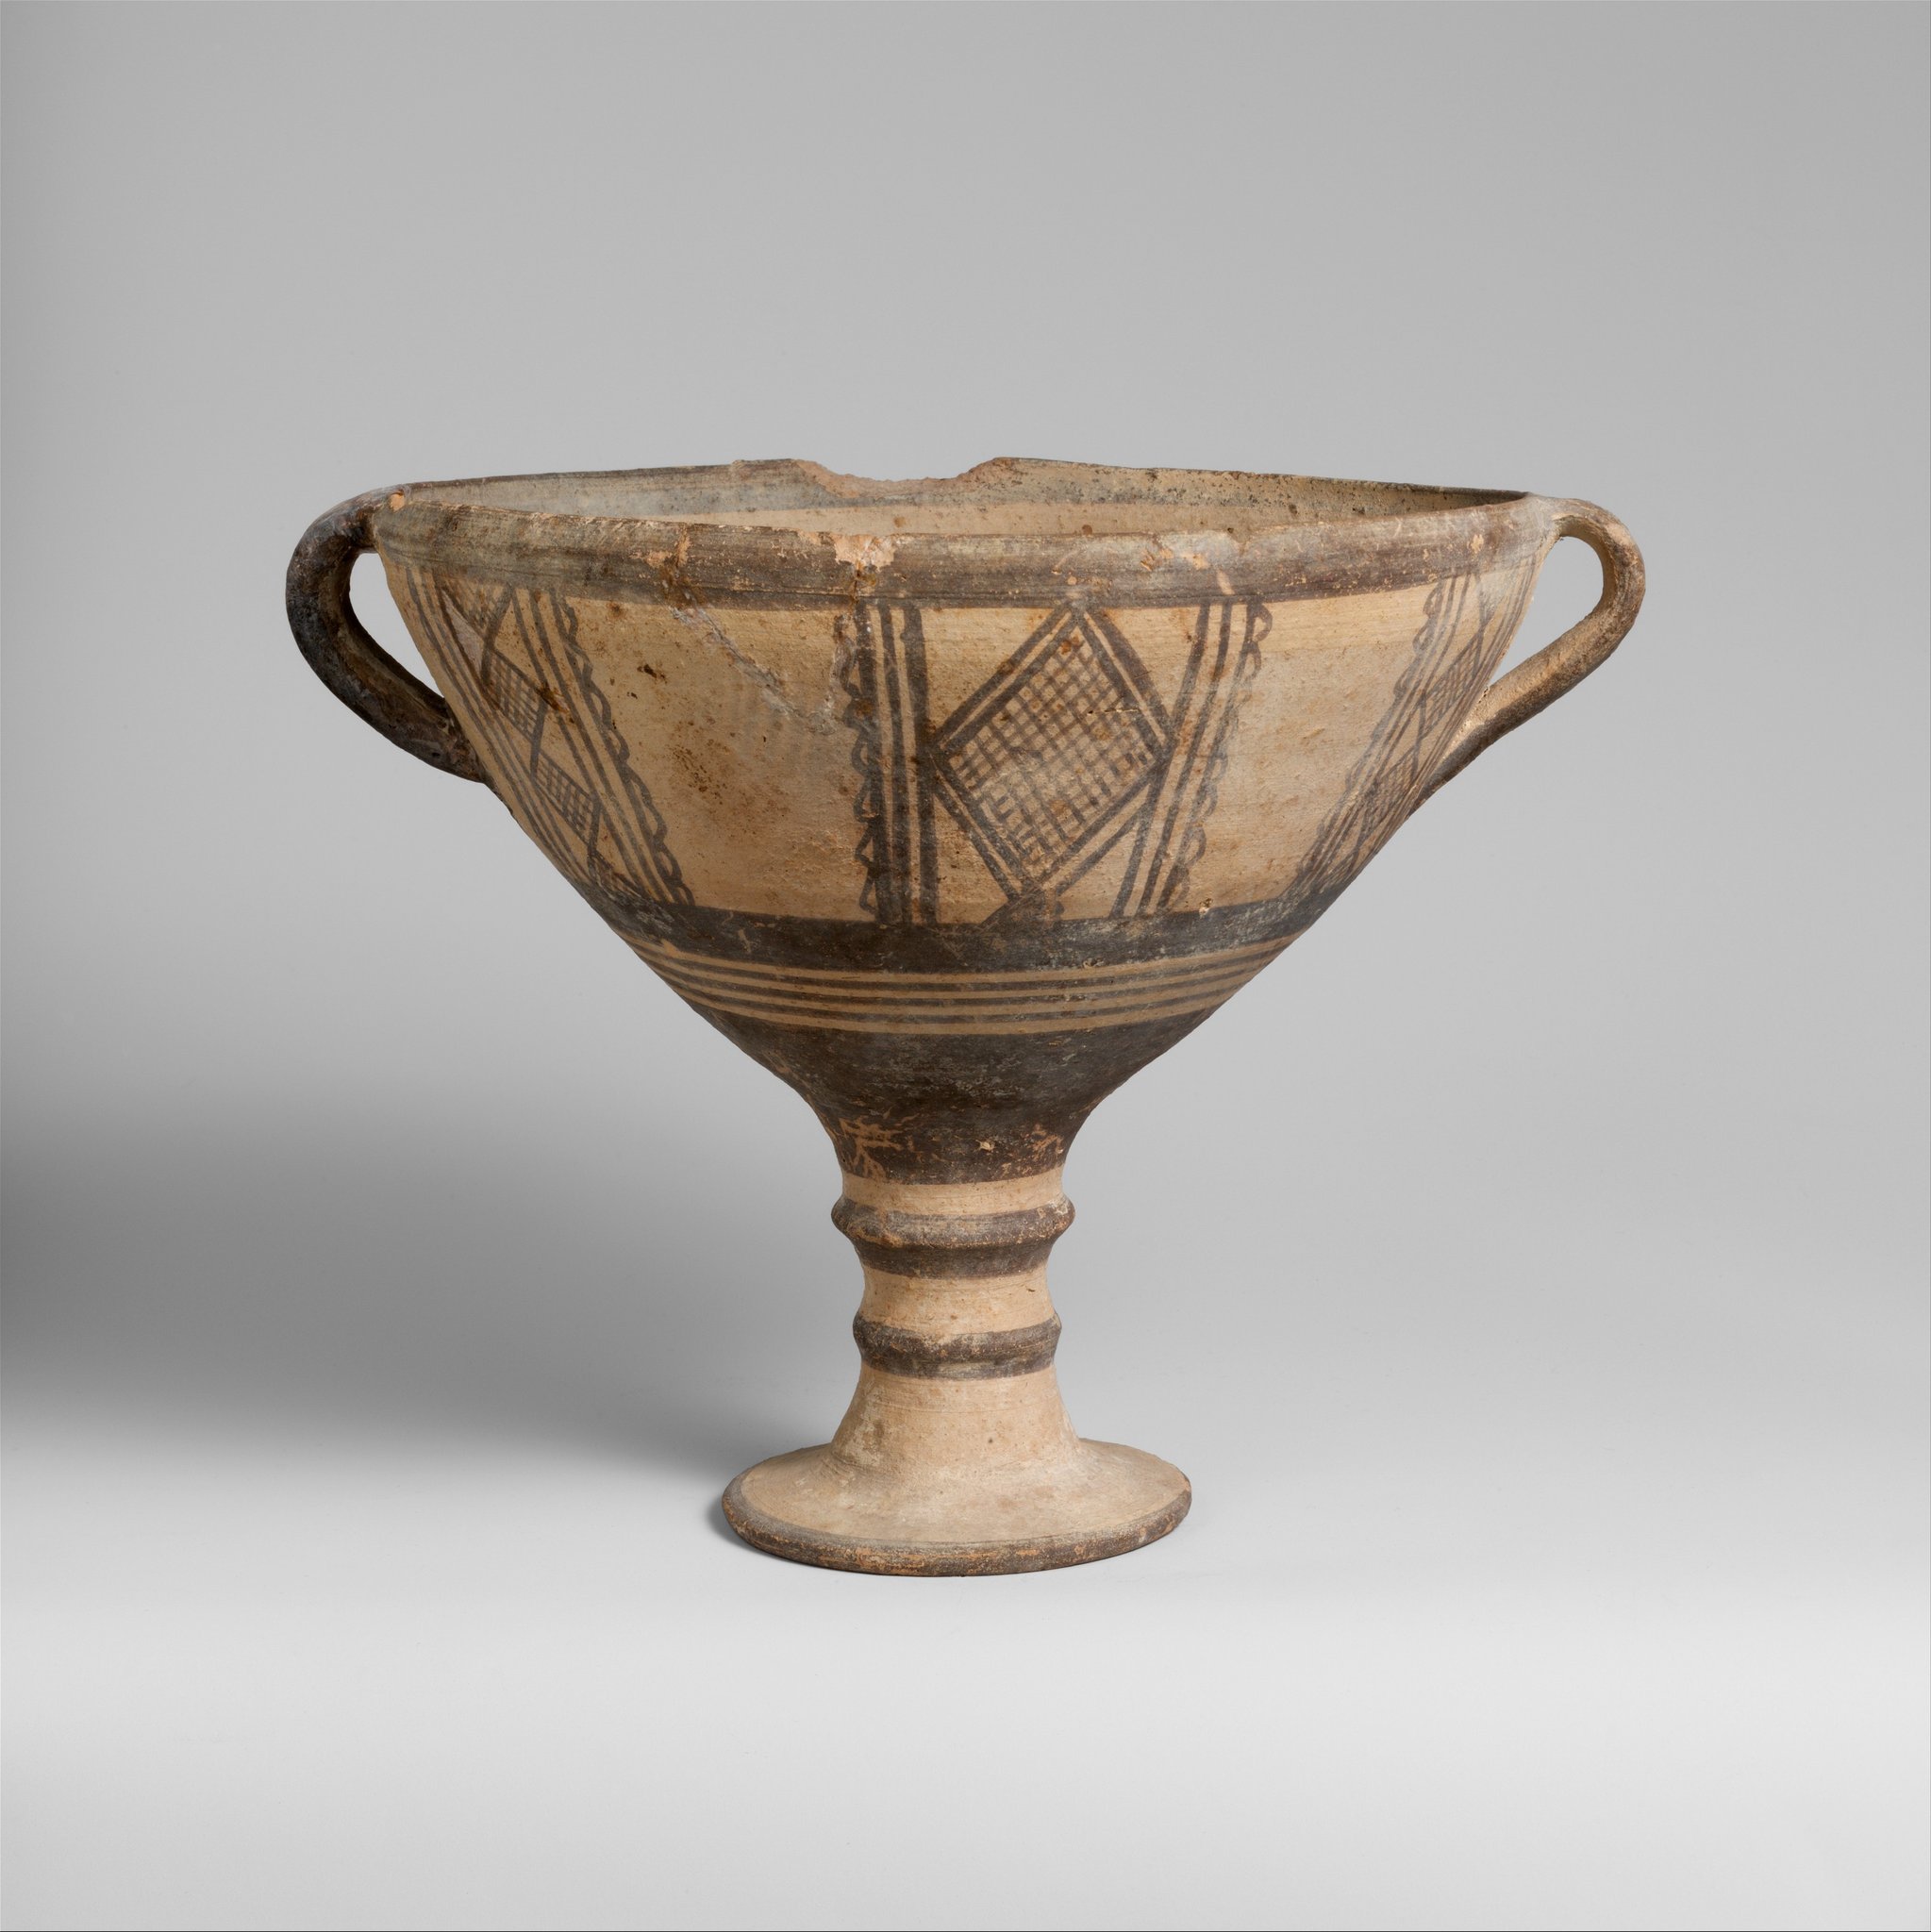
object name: kylix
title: Terracotta stemmed cup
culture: cypriot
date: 1050-950 BCE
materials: terracotta